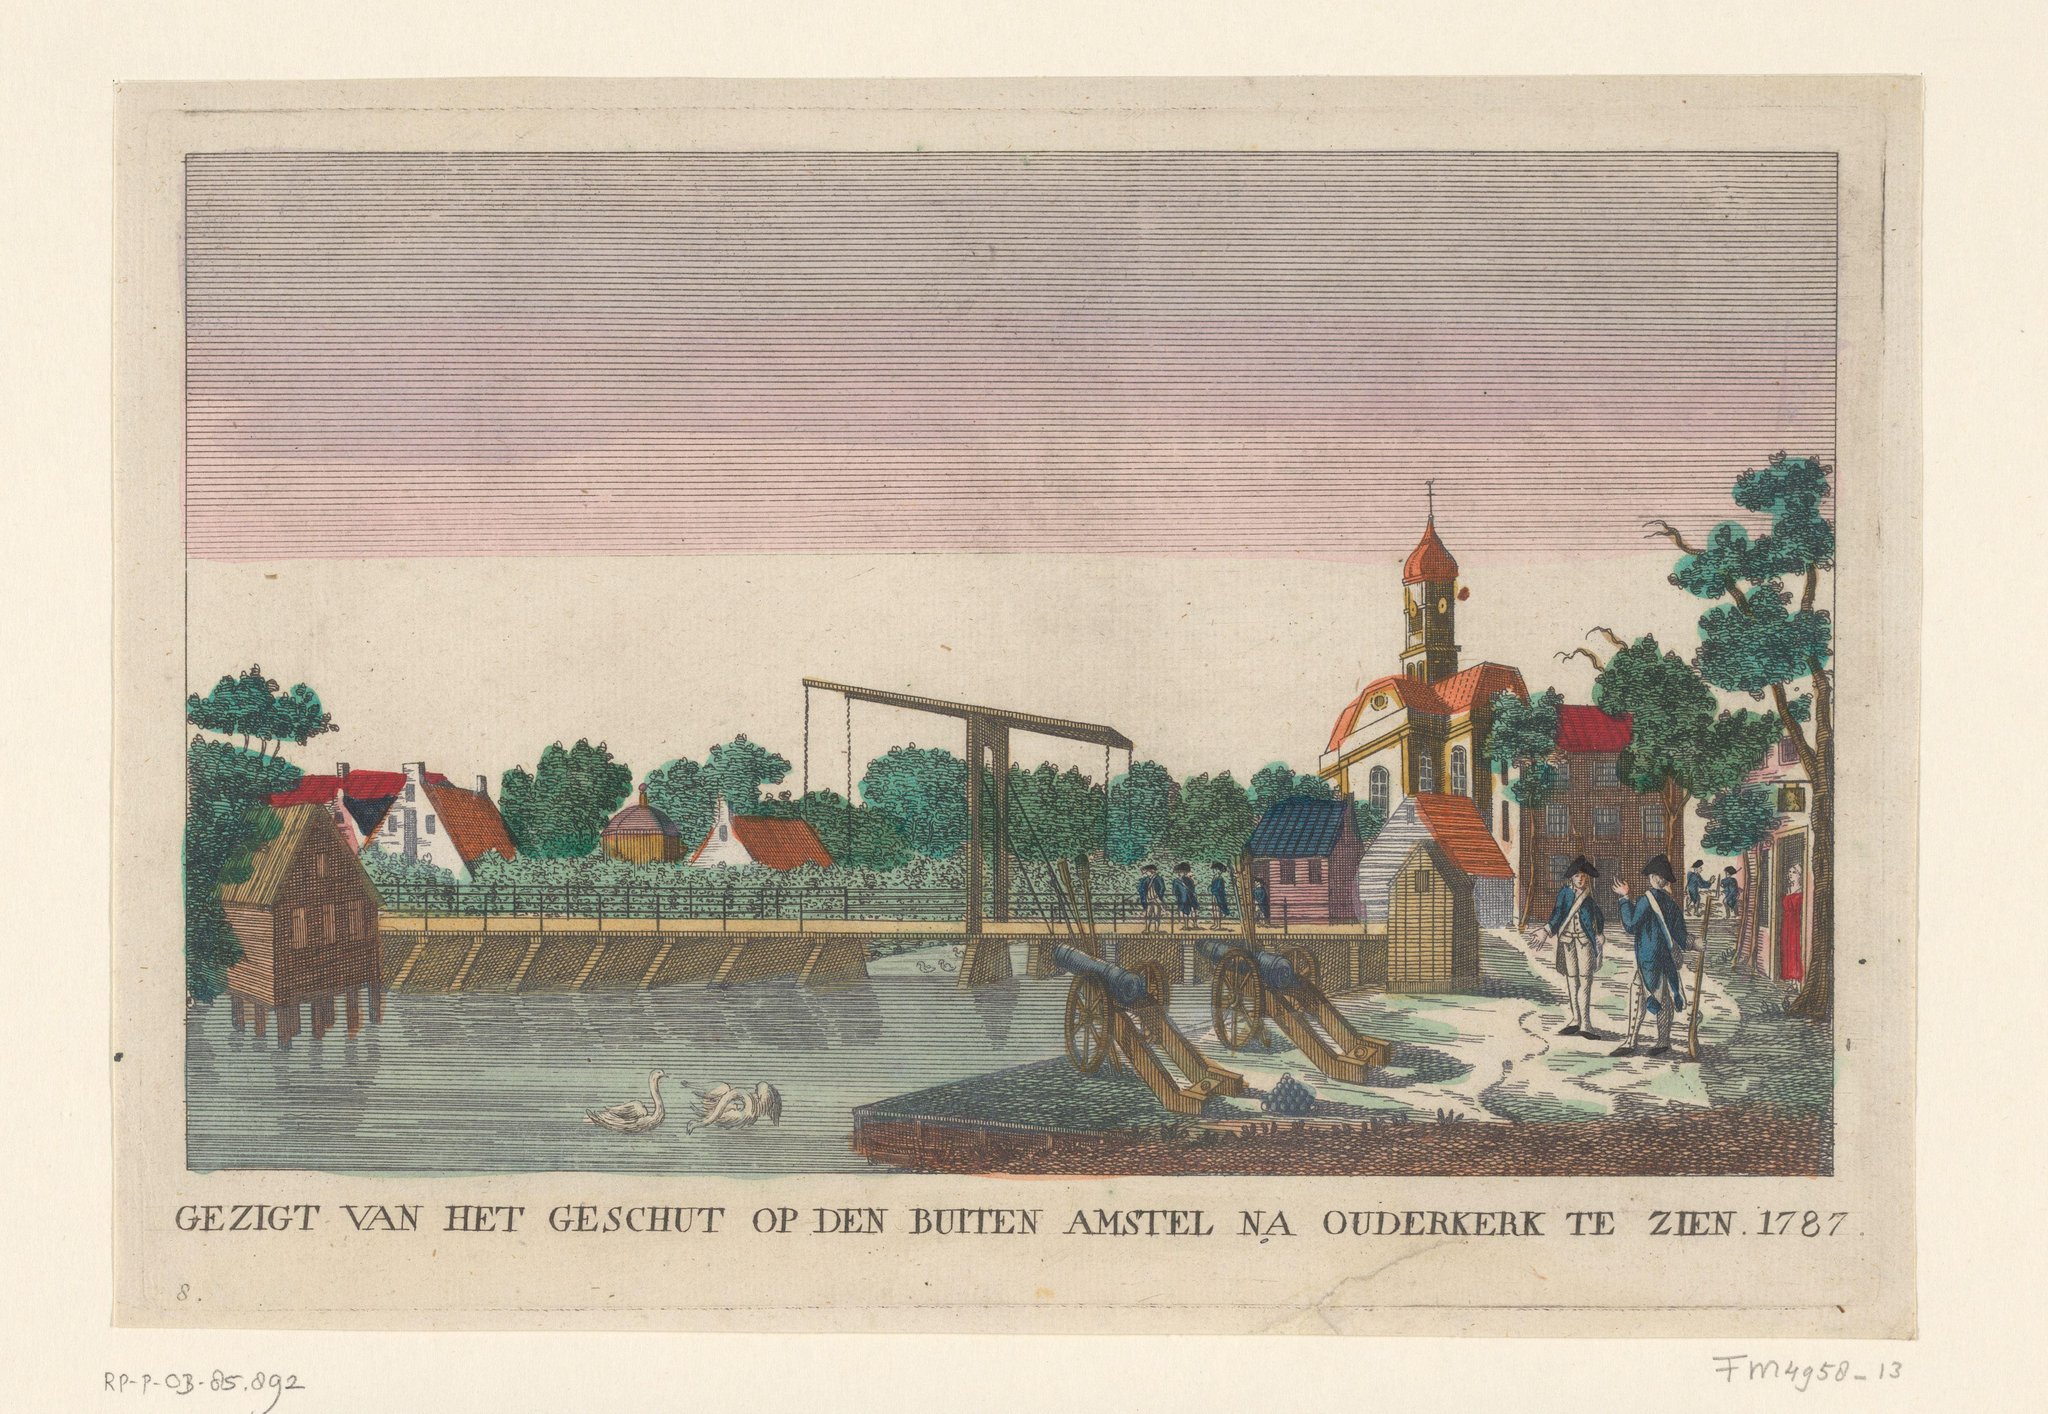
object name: print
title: Batterij te Ouderkerk, 1787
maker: Anonymous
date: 1787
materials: paper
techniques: etching, hand coloring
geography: northern netherlands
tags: defence of fortification or city, defensive measures (military)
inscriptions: collector's mark: Lugt 2228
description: Battterij aan de Buitenamstel te Ouderkerk aan de Amstel. Genummerd linksonder: 8. Onderdeel van een serie van drie (van de mogelijk veertien) Duitse platen gekopieerd naar de reeksen van veertien platen van de verdedigingen aangelegd door de patriotten rondom Amsterdam ten tijde van de inval van de Pruisische troepen in september 1787.